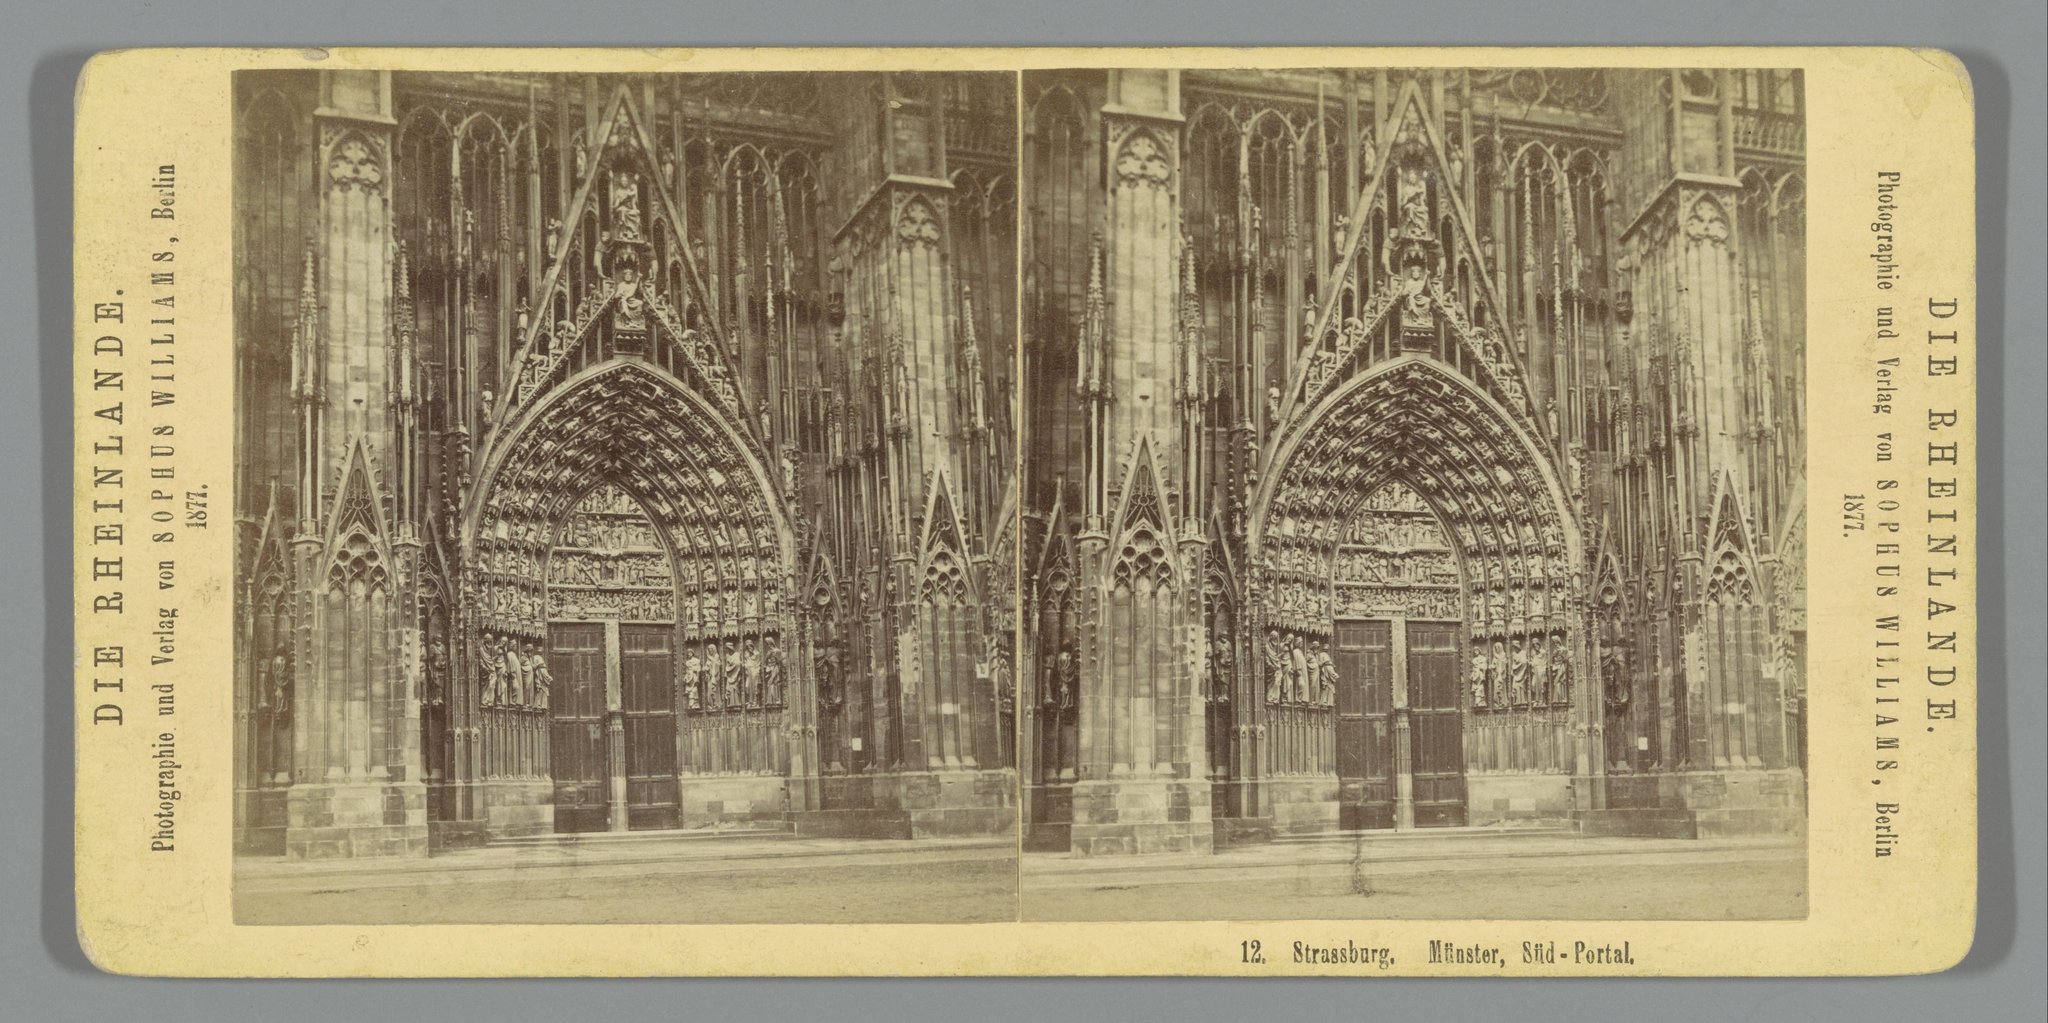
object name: stereograph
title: Strassburg, Münster, Süd-Portal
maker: sophus williams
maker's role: publisher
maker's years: 1835-1900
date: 1877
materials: cardboard, photographic support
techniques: albumen print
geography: berlin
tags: parts of church exterior and annexes: portal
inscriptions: number: ‘12.’